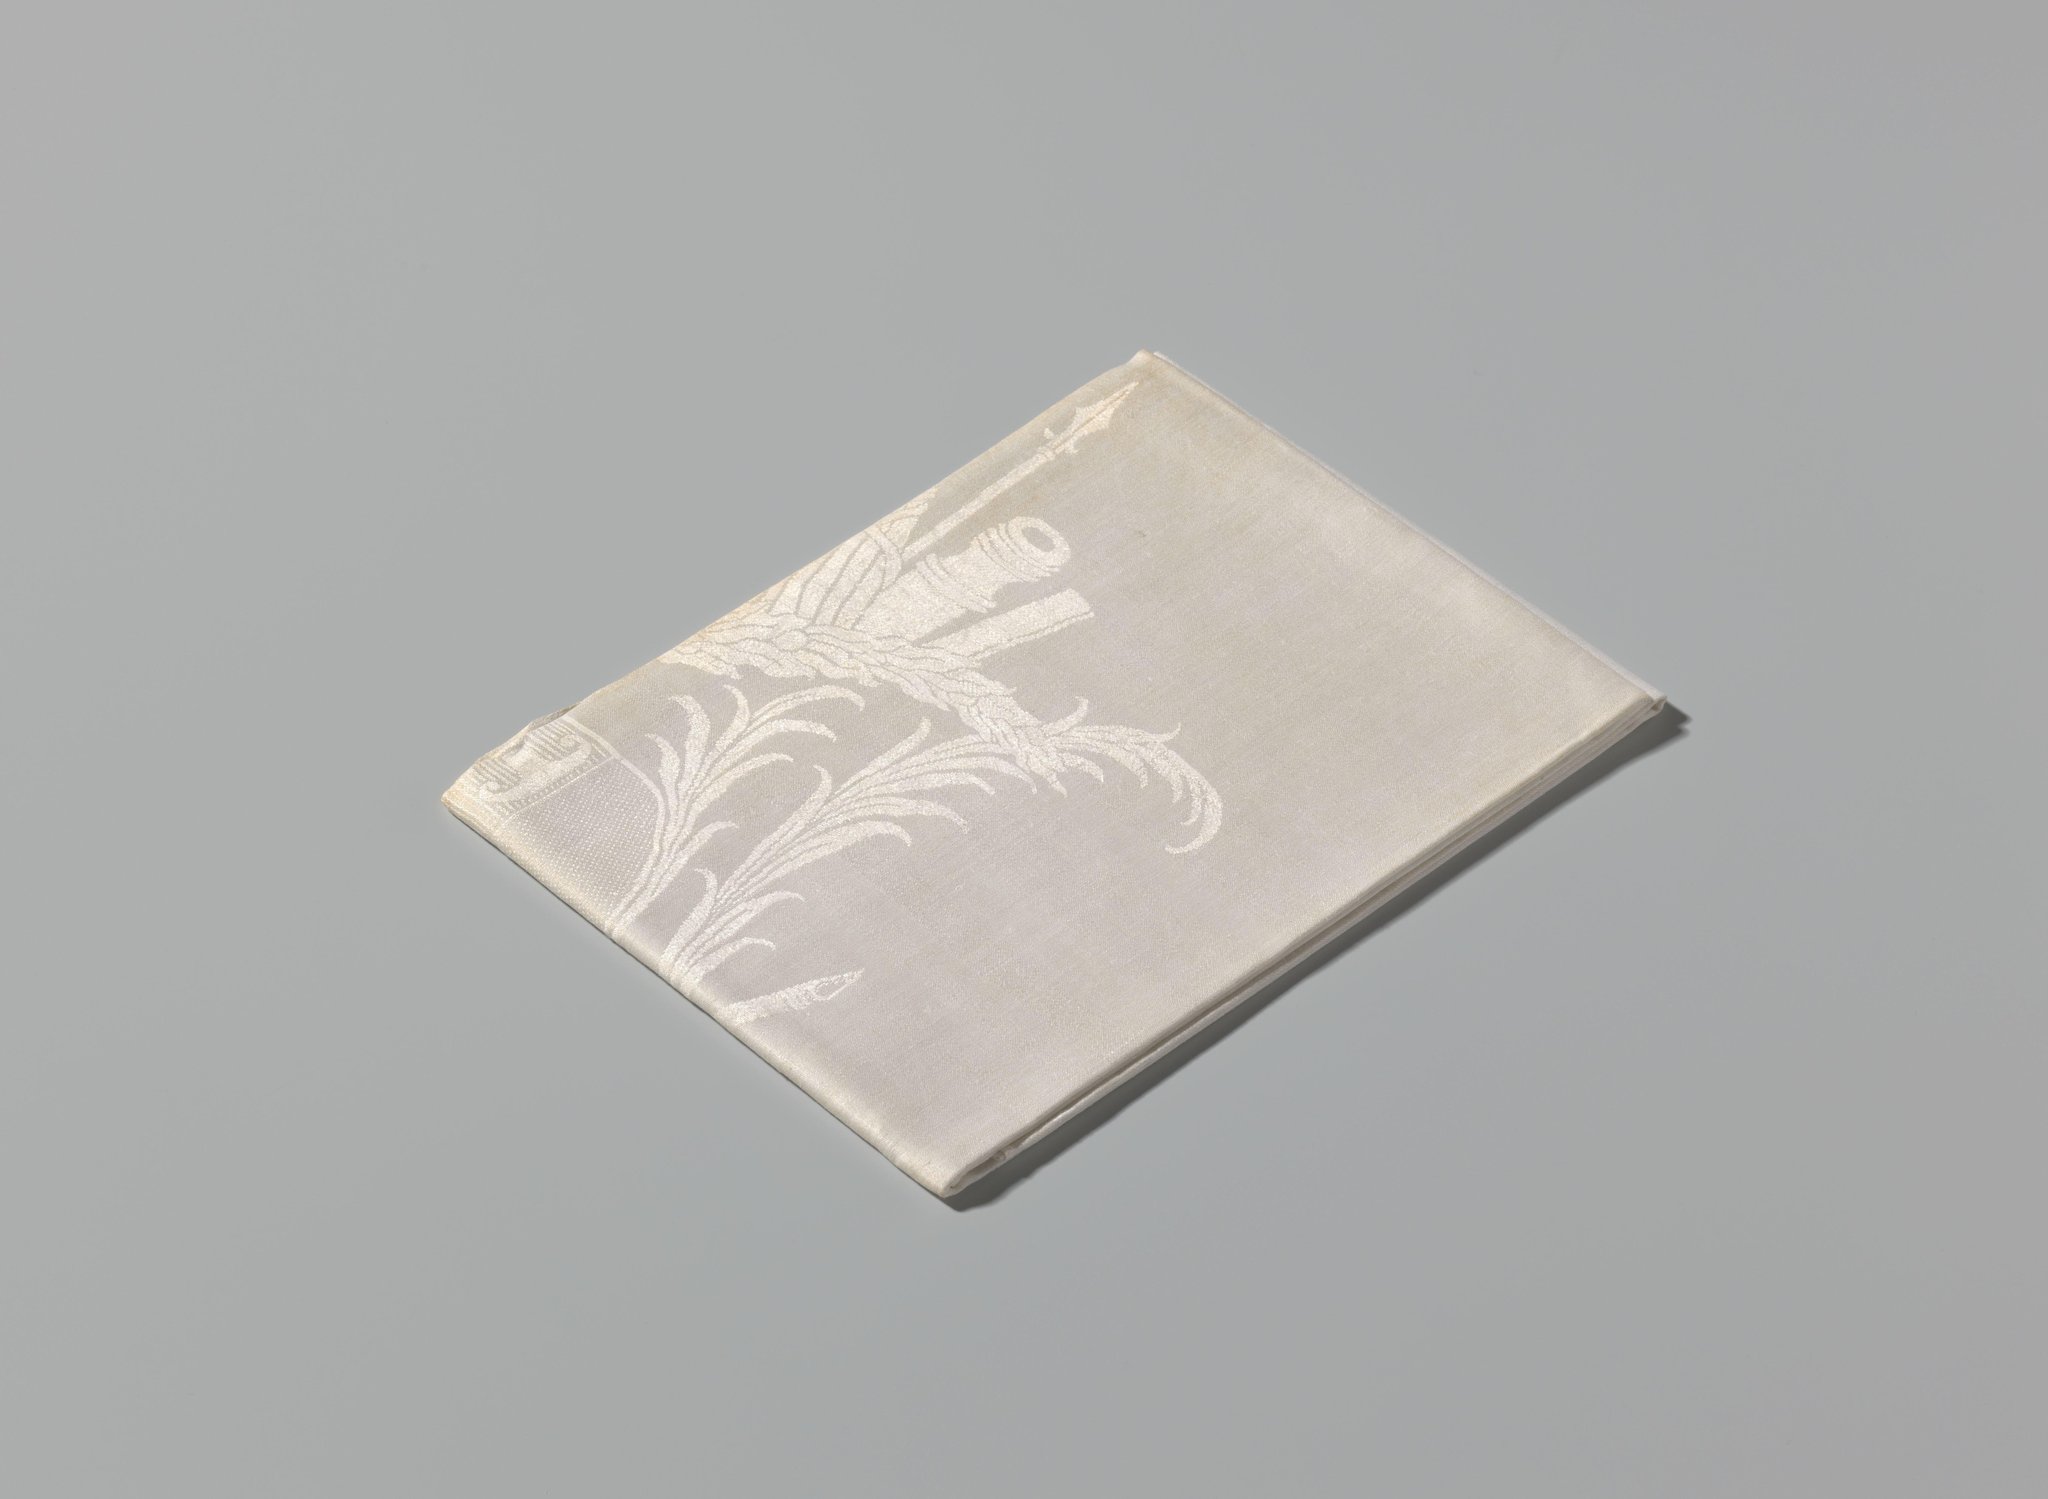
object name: napkin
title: Servet met het wapen van Wijk bij Duurstede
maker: Anonymous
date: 1786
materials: linen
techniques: damask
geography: north brabant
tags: wijk bij duurstede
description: Servet van linnendamast met het wapen van Wijk bij Duurstede. Middenveld: In de breedte geplaatst voor een speer met vrijheidshoed, het wapen van Wijk bij Duurstede: goud met balk van keel, beladen met drie zuilen; het is omgeven door twee lauwertakken en rust op een trofee van bajonetten, vlaggen, vuurmond en fascesbundel. Daaronder: 20 MAART Ao 1786 en daarboven DAN 36. Randen: slingerende tak met eikebladeren en eikels, een effen bandlijst en een blokkenrand.